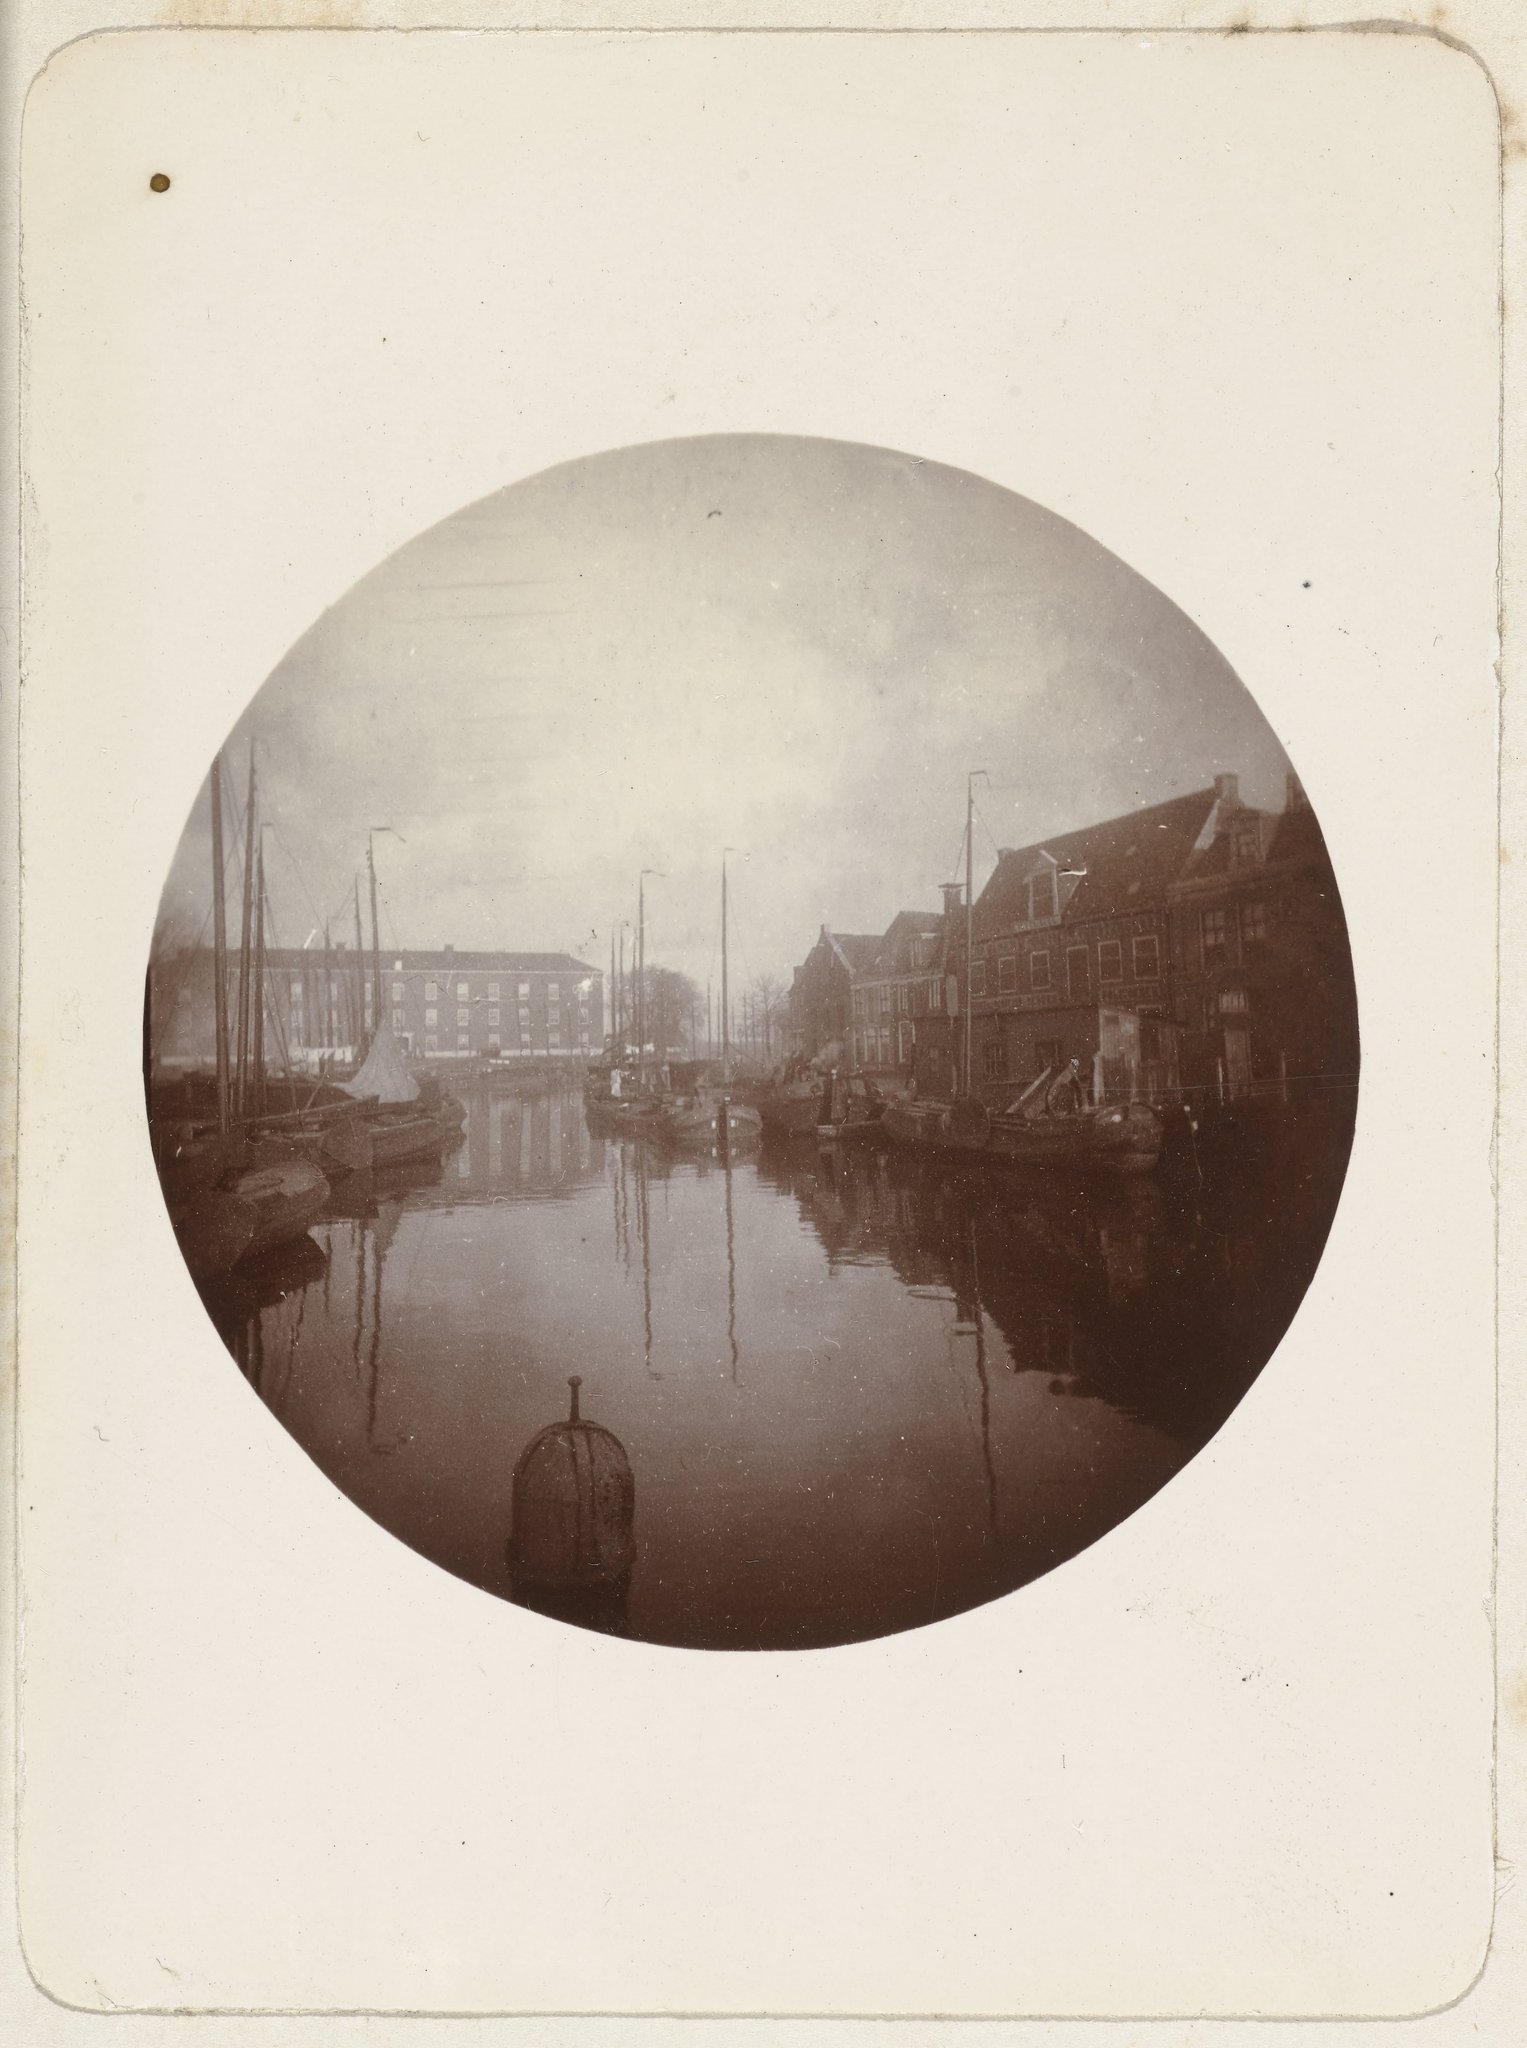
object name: photograph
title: Oostersingel met aangemeerde schepen in Leeuwarden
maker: Anonymous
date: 1897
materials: paper, cardboard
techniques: gelatin silver print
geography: leeuwarden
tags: harbour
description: Oostersingel met aangemeerde schepen in Leeuwarden, gezien vanaf de Vlietserbrug. De foto is onderdeel van een albumblad met daarop foto's van Leeuwarden.